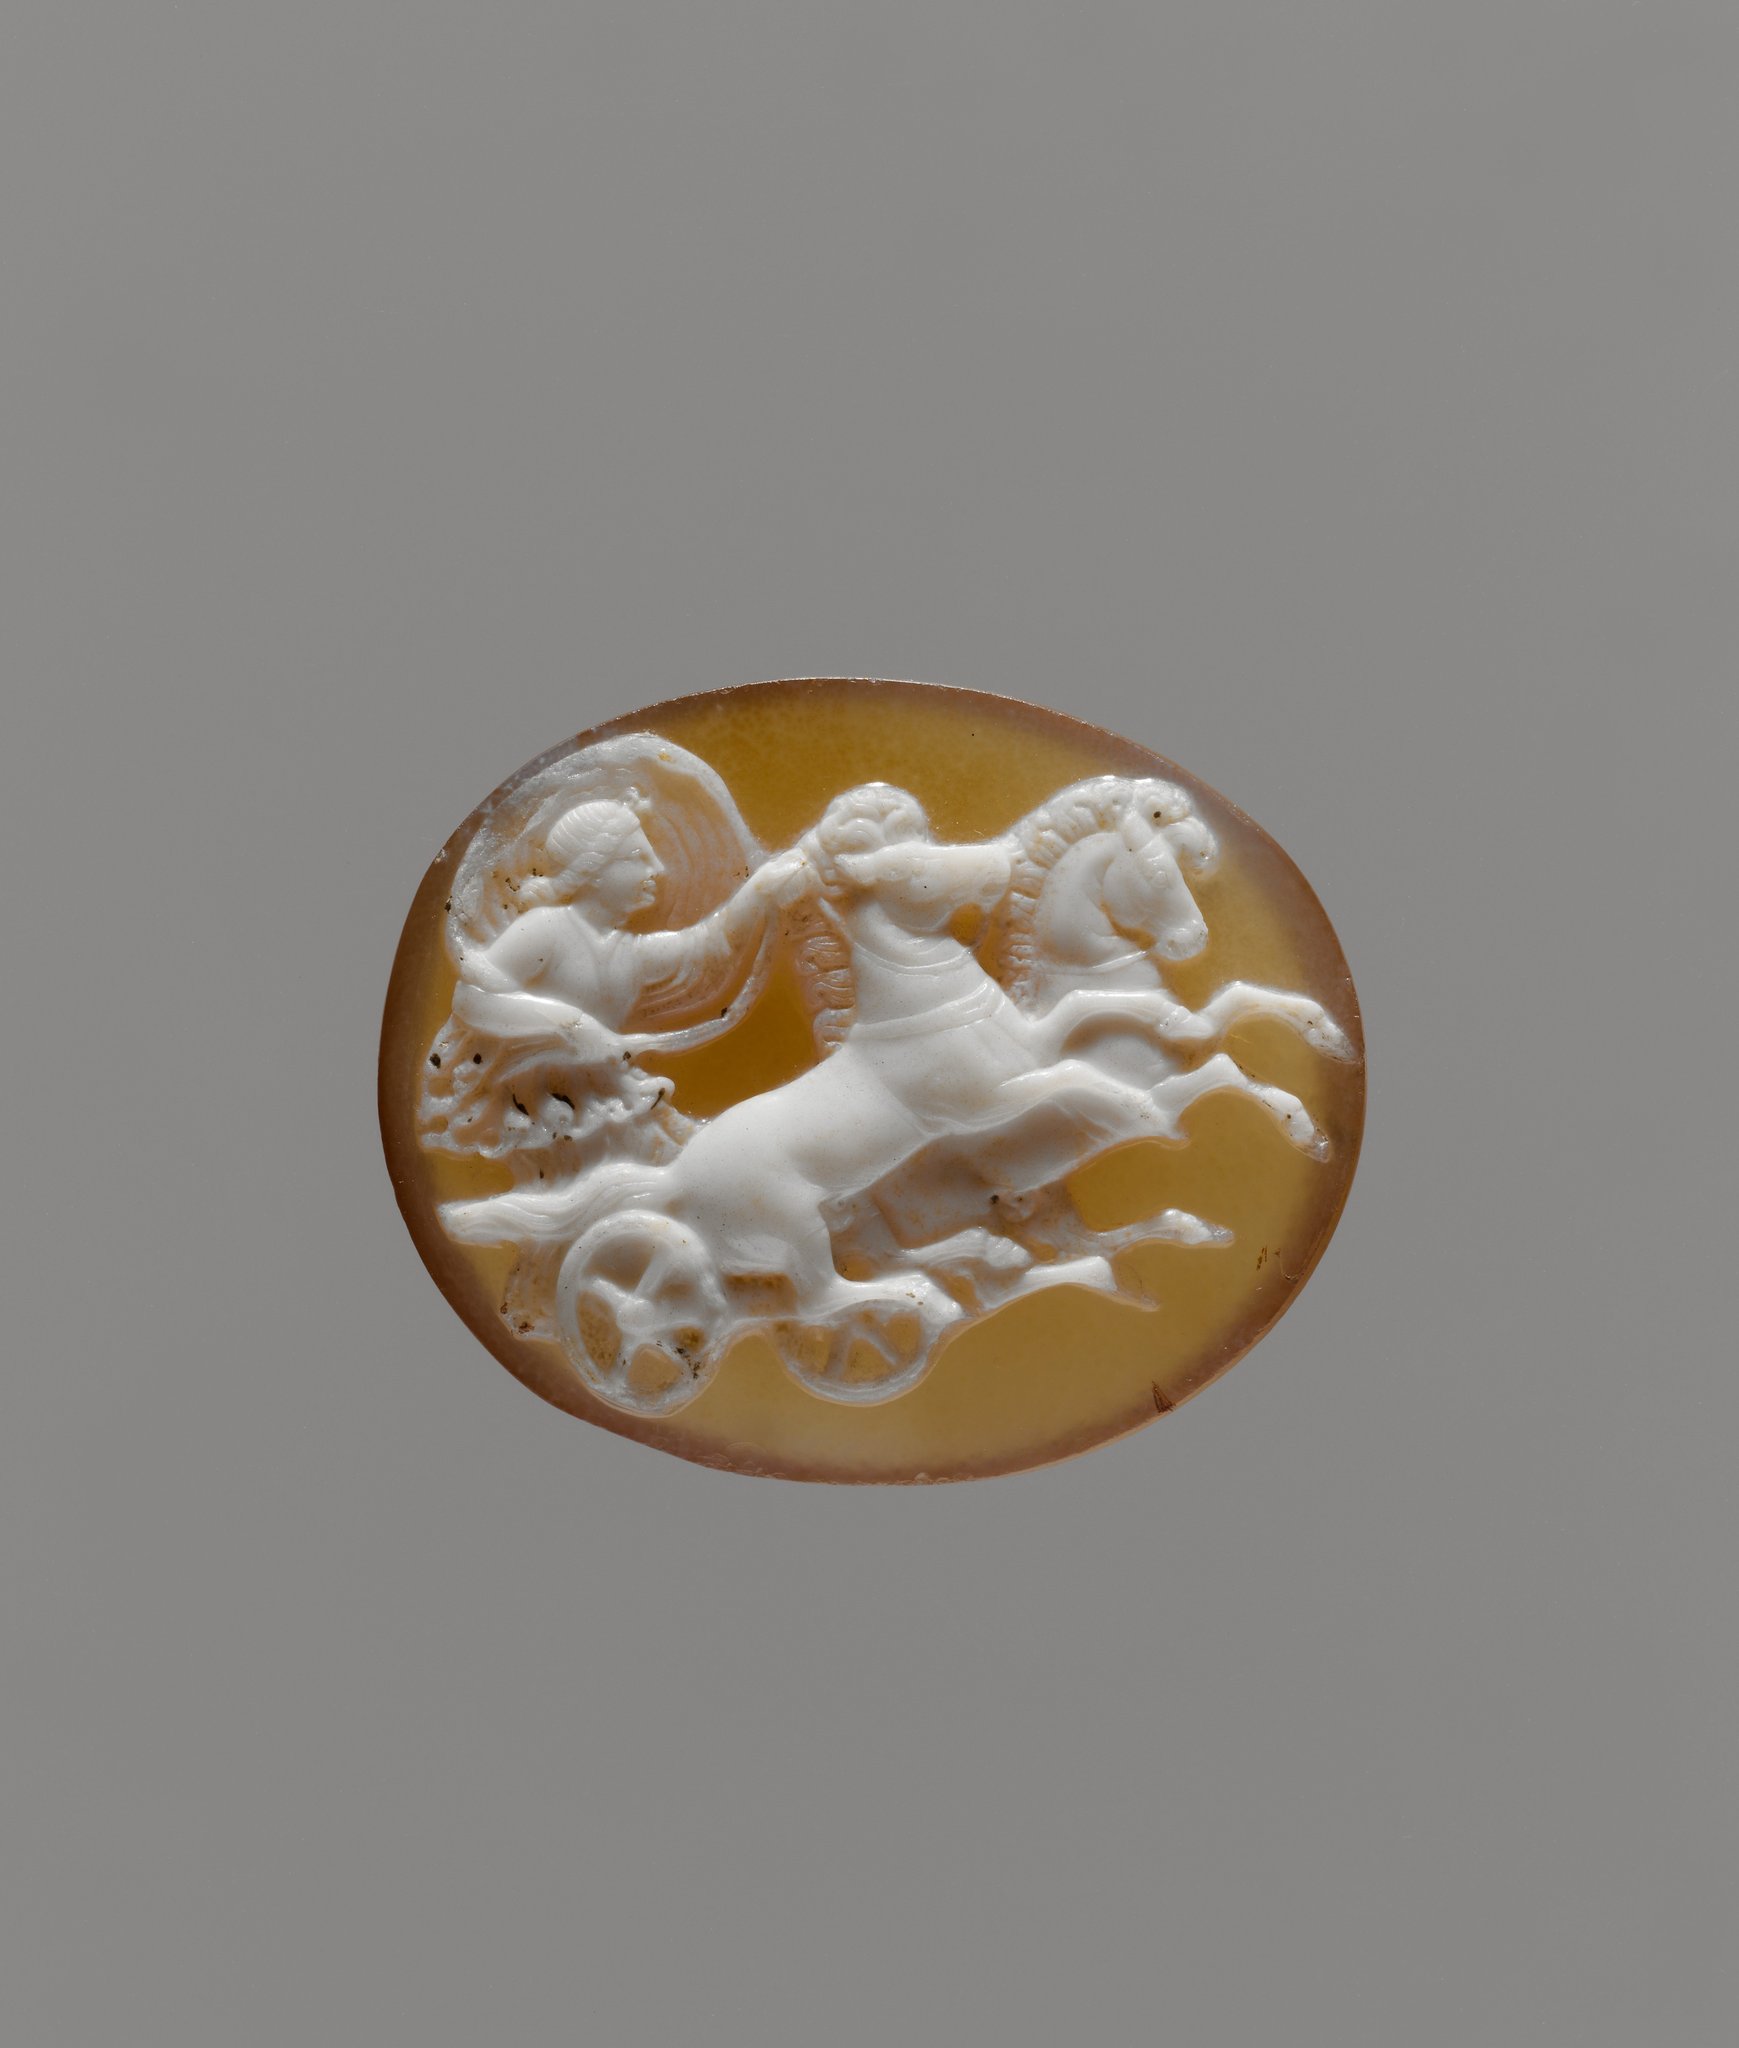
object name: cameo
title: Sardonyx cameo of Aurora in a chariot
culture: greek or roman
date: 100 BCE-100 CE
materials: gold, gemstone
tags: horses,goddess,chariots